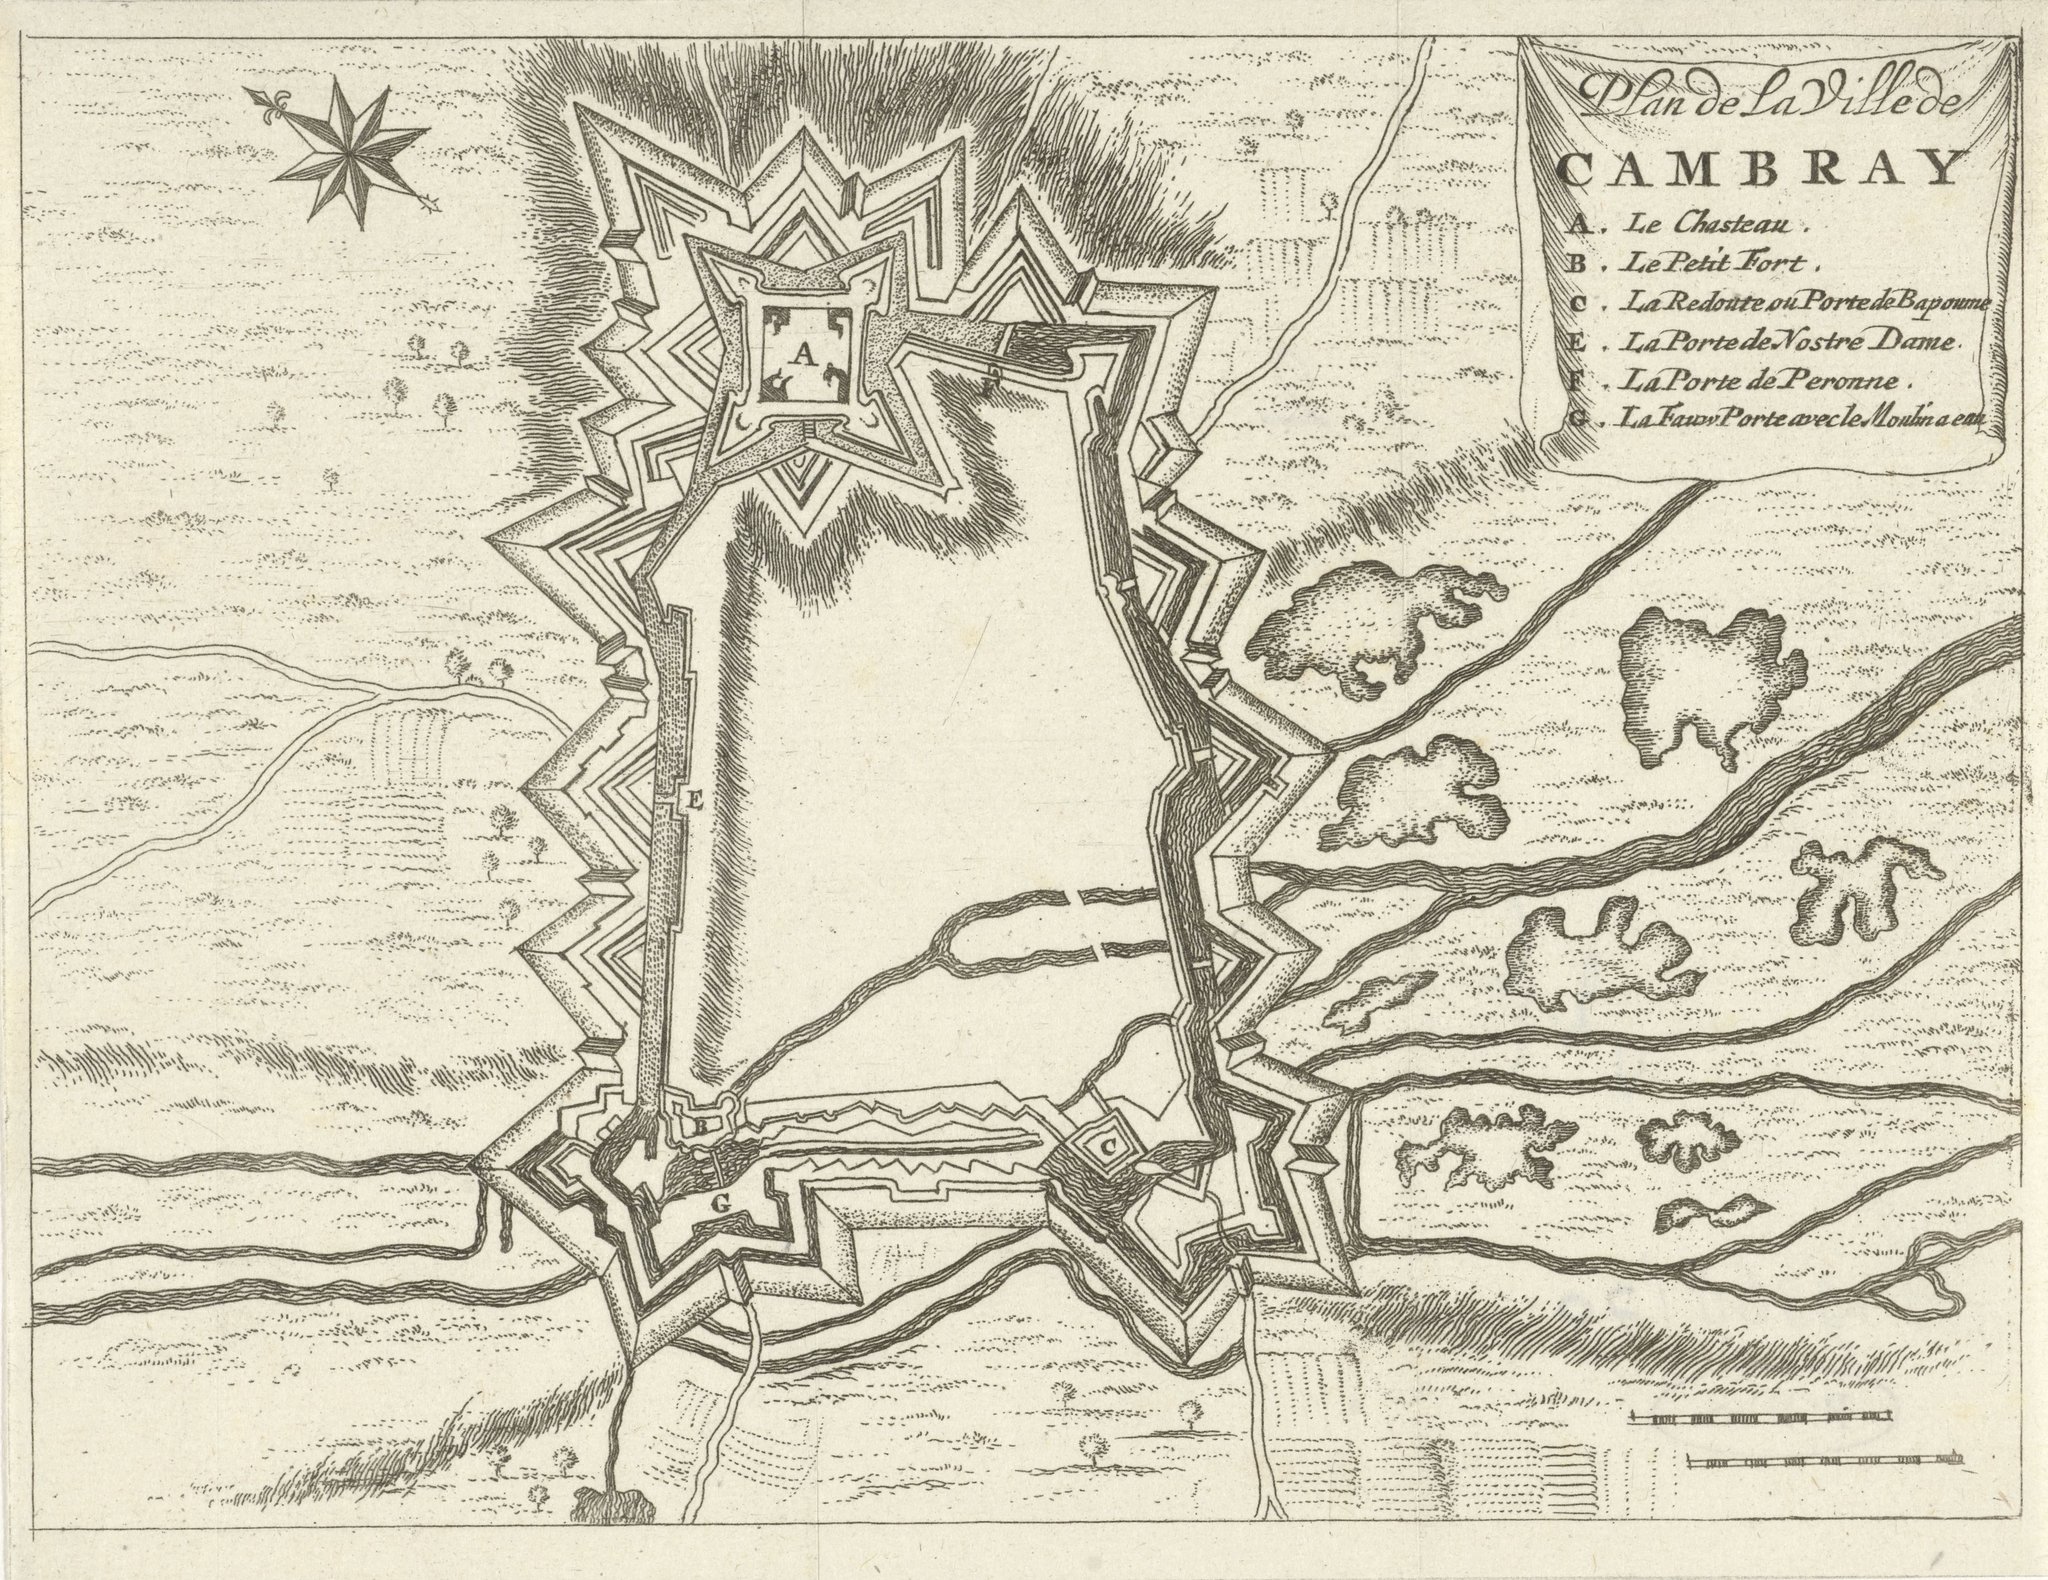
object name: print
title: Plan de la Ville de Cambray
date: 1673-1686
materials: paper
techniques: etching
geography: amsterdam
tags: maps of cities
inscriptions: collector's mark: Lugt 2228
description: Illustratie opgenomen in: Le Mercure hollandois, contenant les choses les plus remarquables, 13 delen. Amsterdam: Hendrick en Dirk Boom, 1673-1686, dl. VI, p. 19.